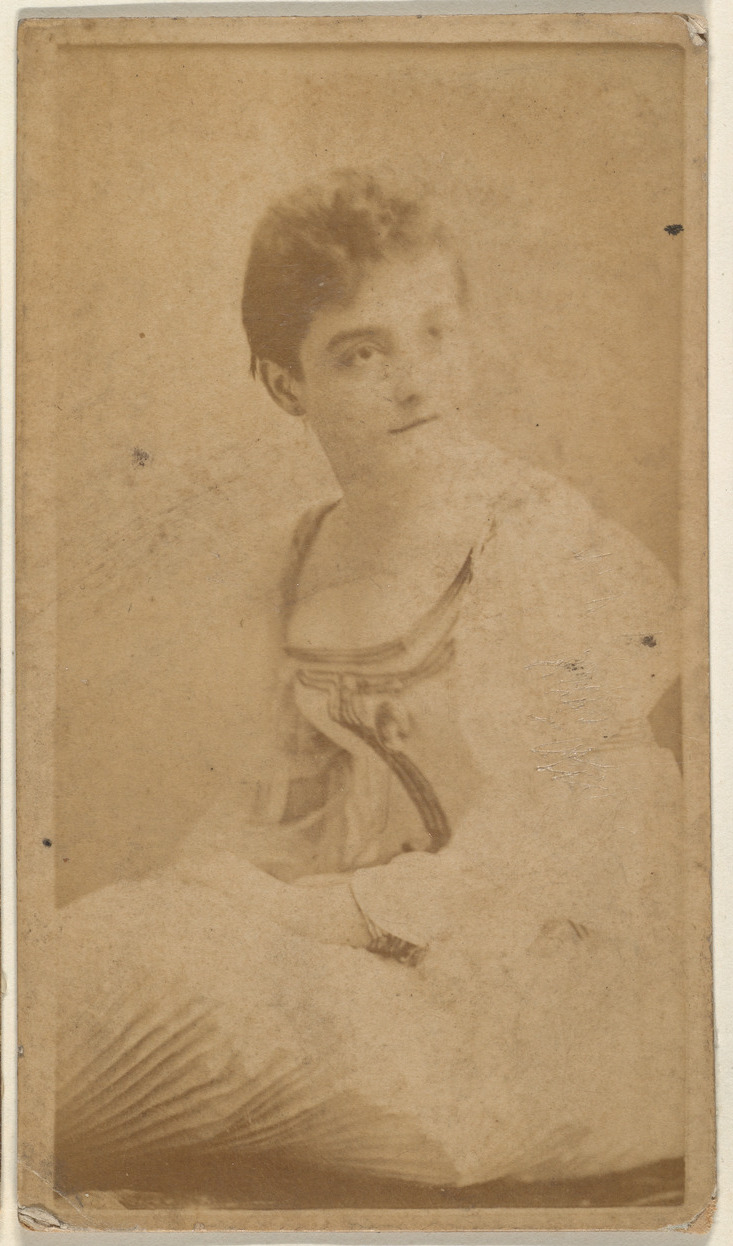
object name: photograph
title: Seated actress, from the Actresses series (N668)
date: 1888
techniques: albumen silver print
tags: portraits,women,actresses